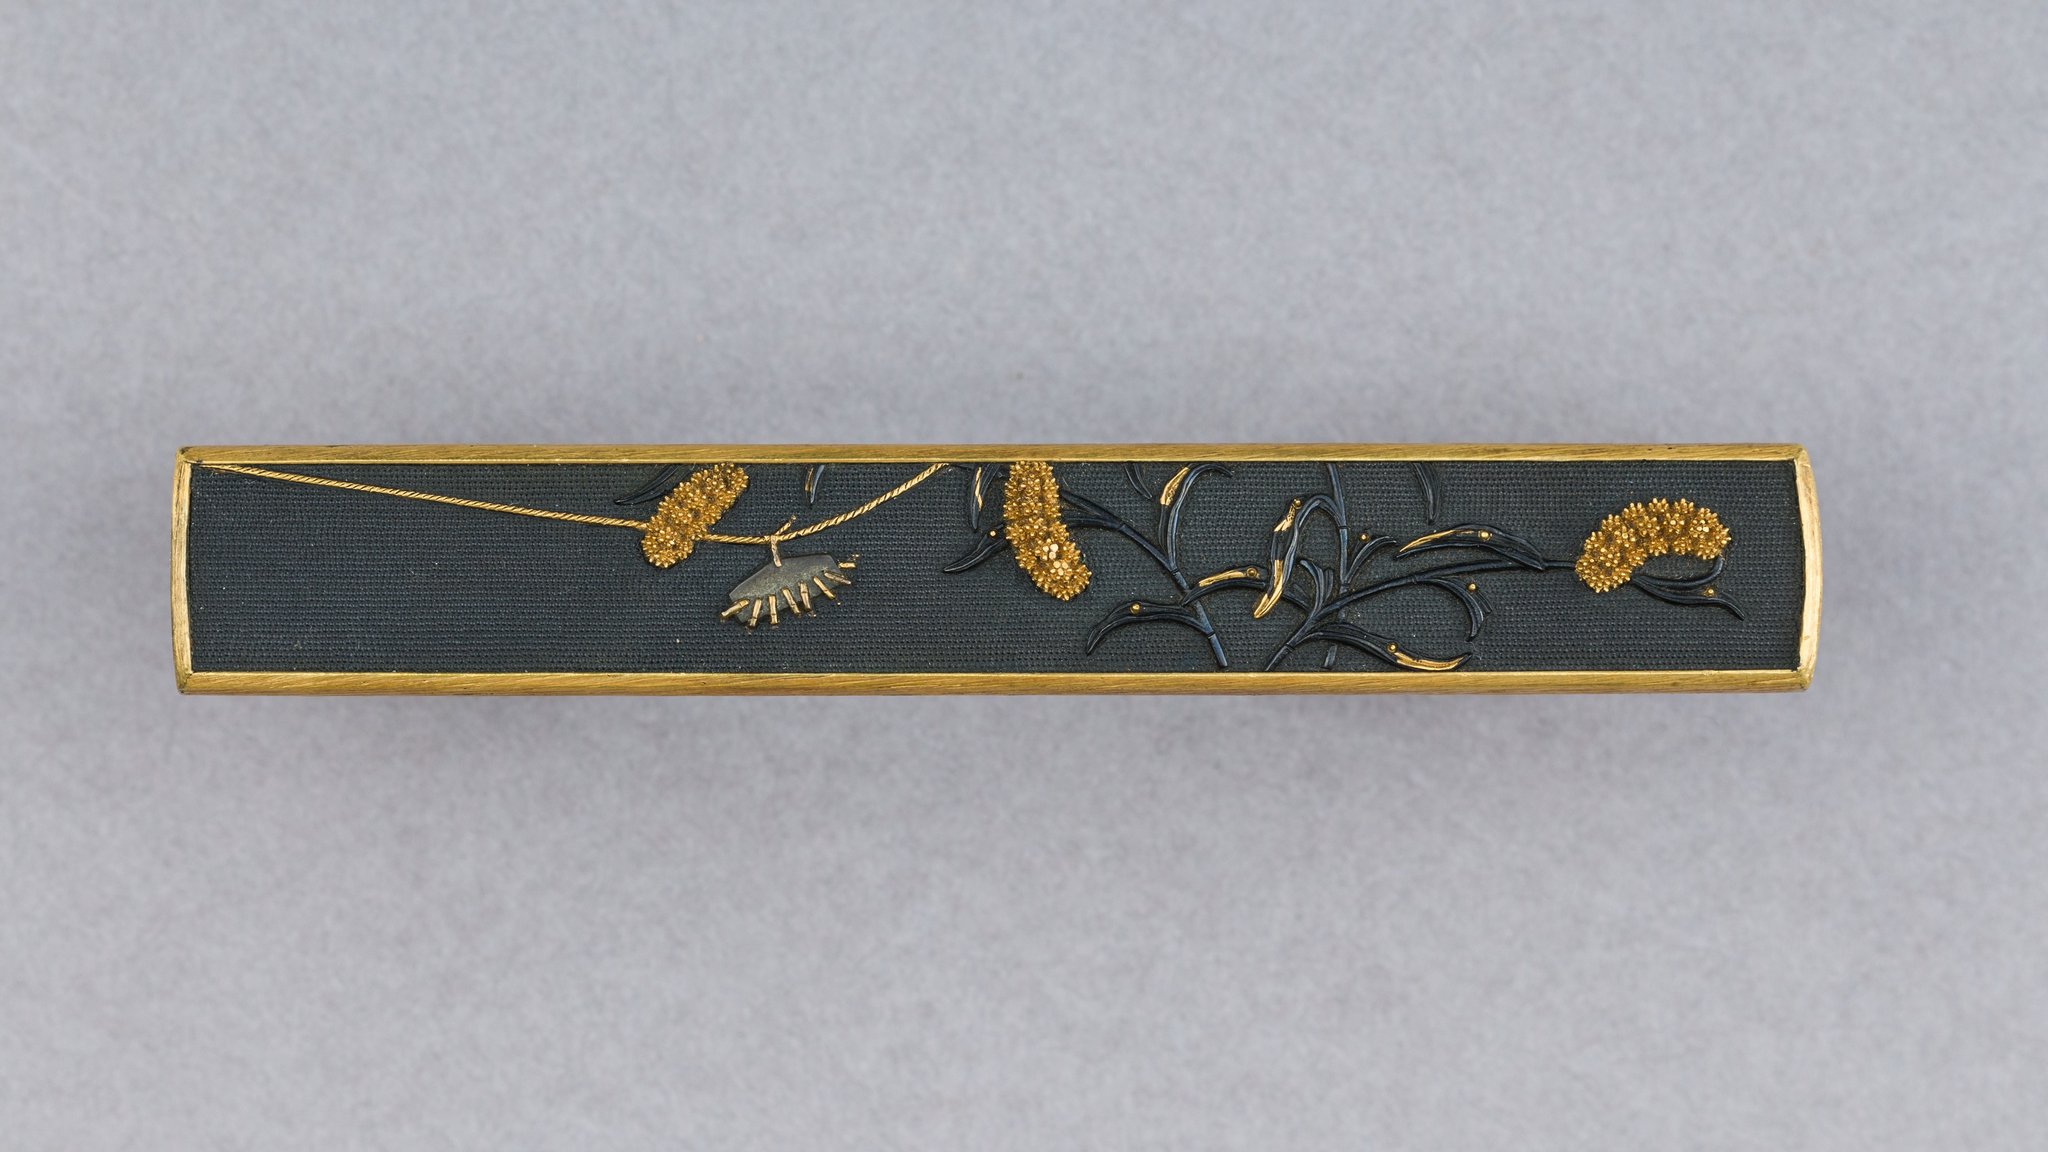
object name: knife handle kozuka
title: Knife Handle (Kozuka)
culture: japanese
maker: ginshōtei tōmei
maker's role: fittings maker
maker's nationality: japanese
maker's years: 1817-1870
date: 1801-1900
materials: silver alloy, gold, iron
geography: japan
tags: plants